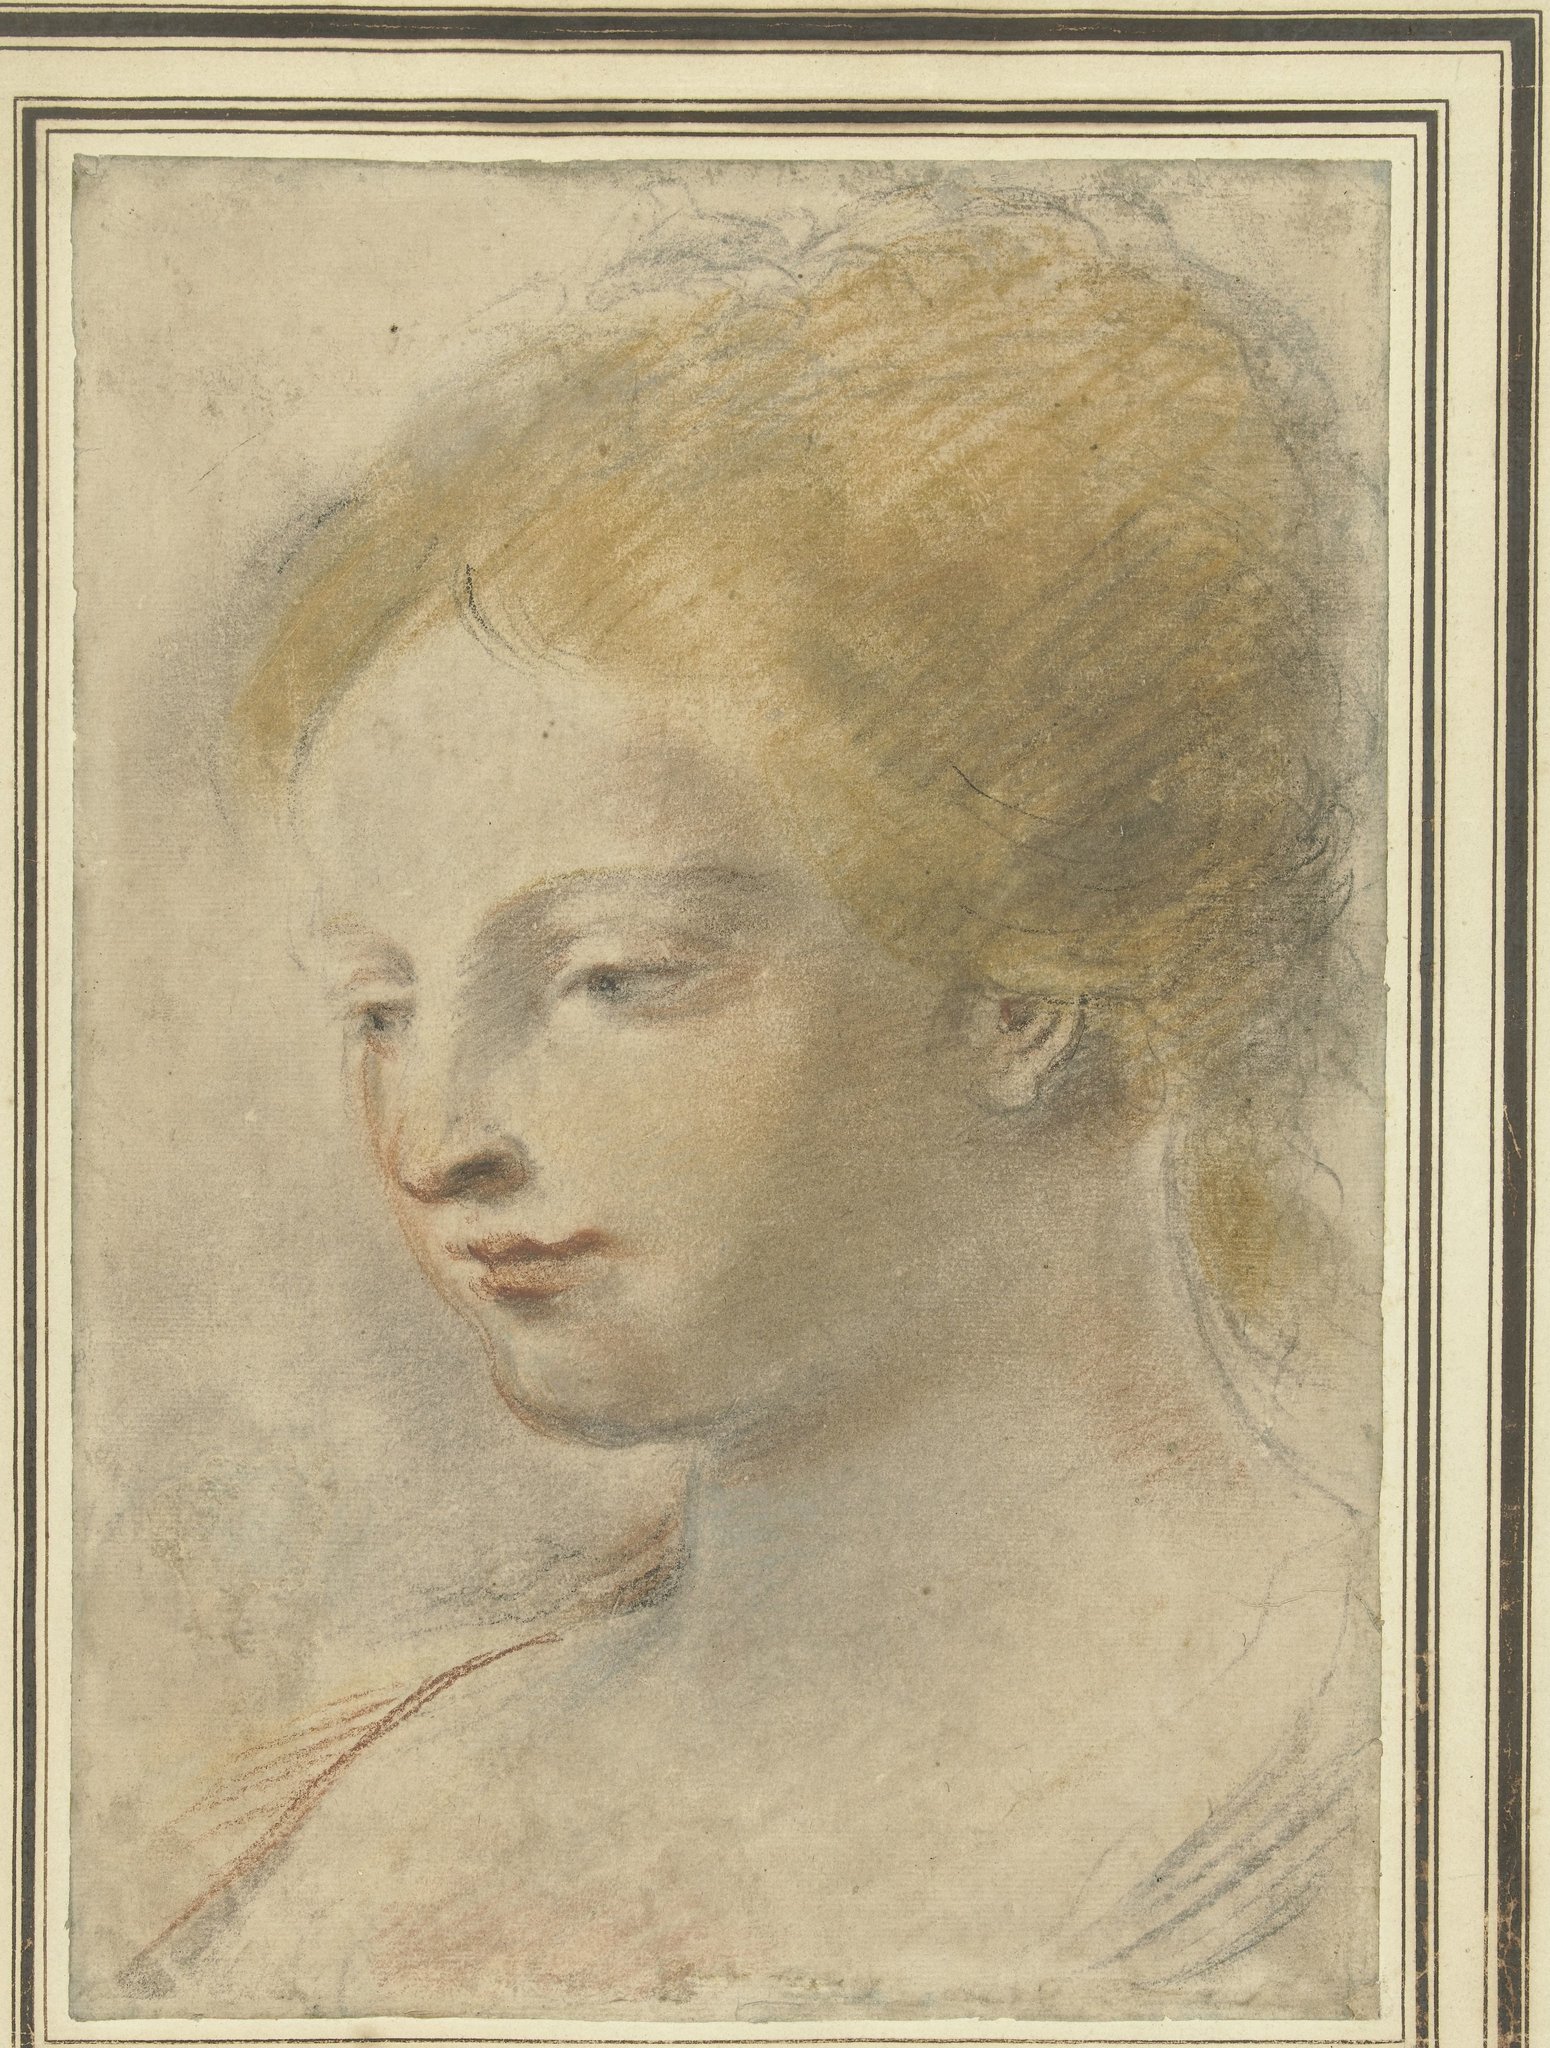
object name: drawing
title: Hoofd van een jonge vrouw, met neergeslagen blik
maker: g.jo.franc da cento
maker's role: draughtsman, painter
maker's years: 1591-1666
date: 1601-1666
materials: chalk, paper, pastel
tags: adolescent, young woman, maiden